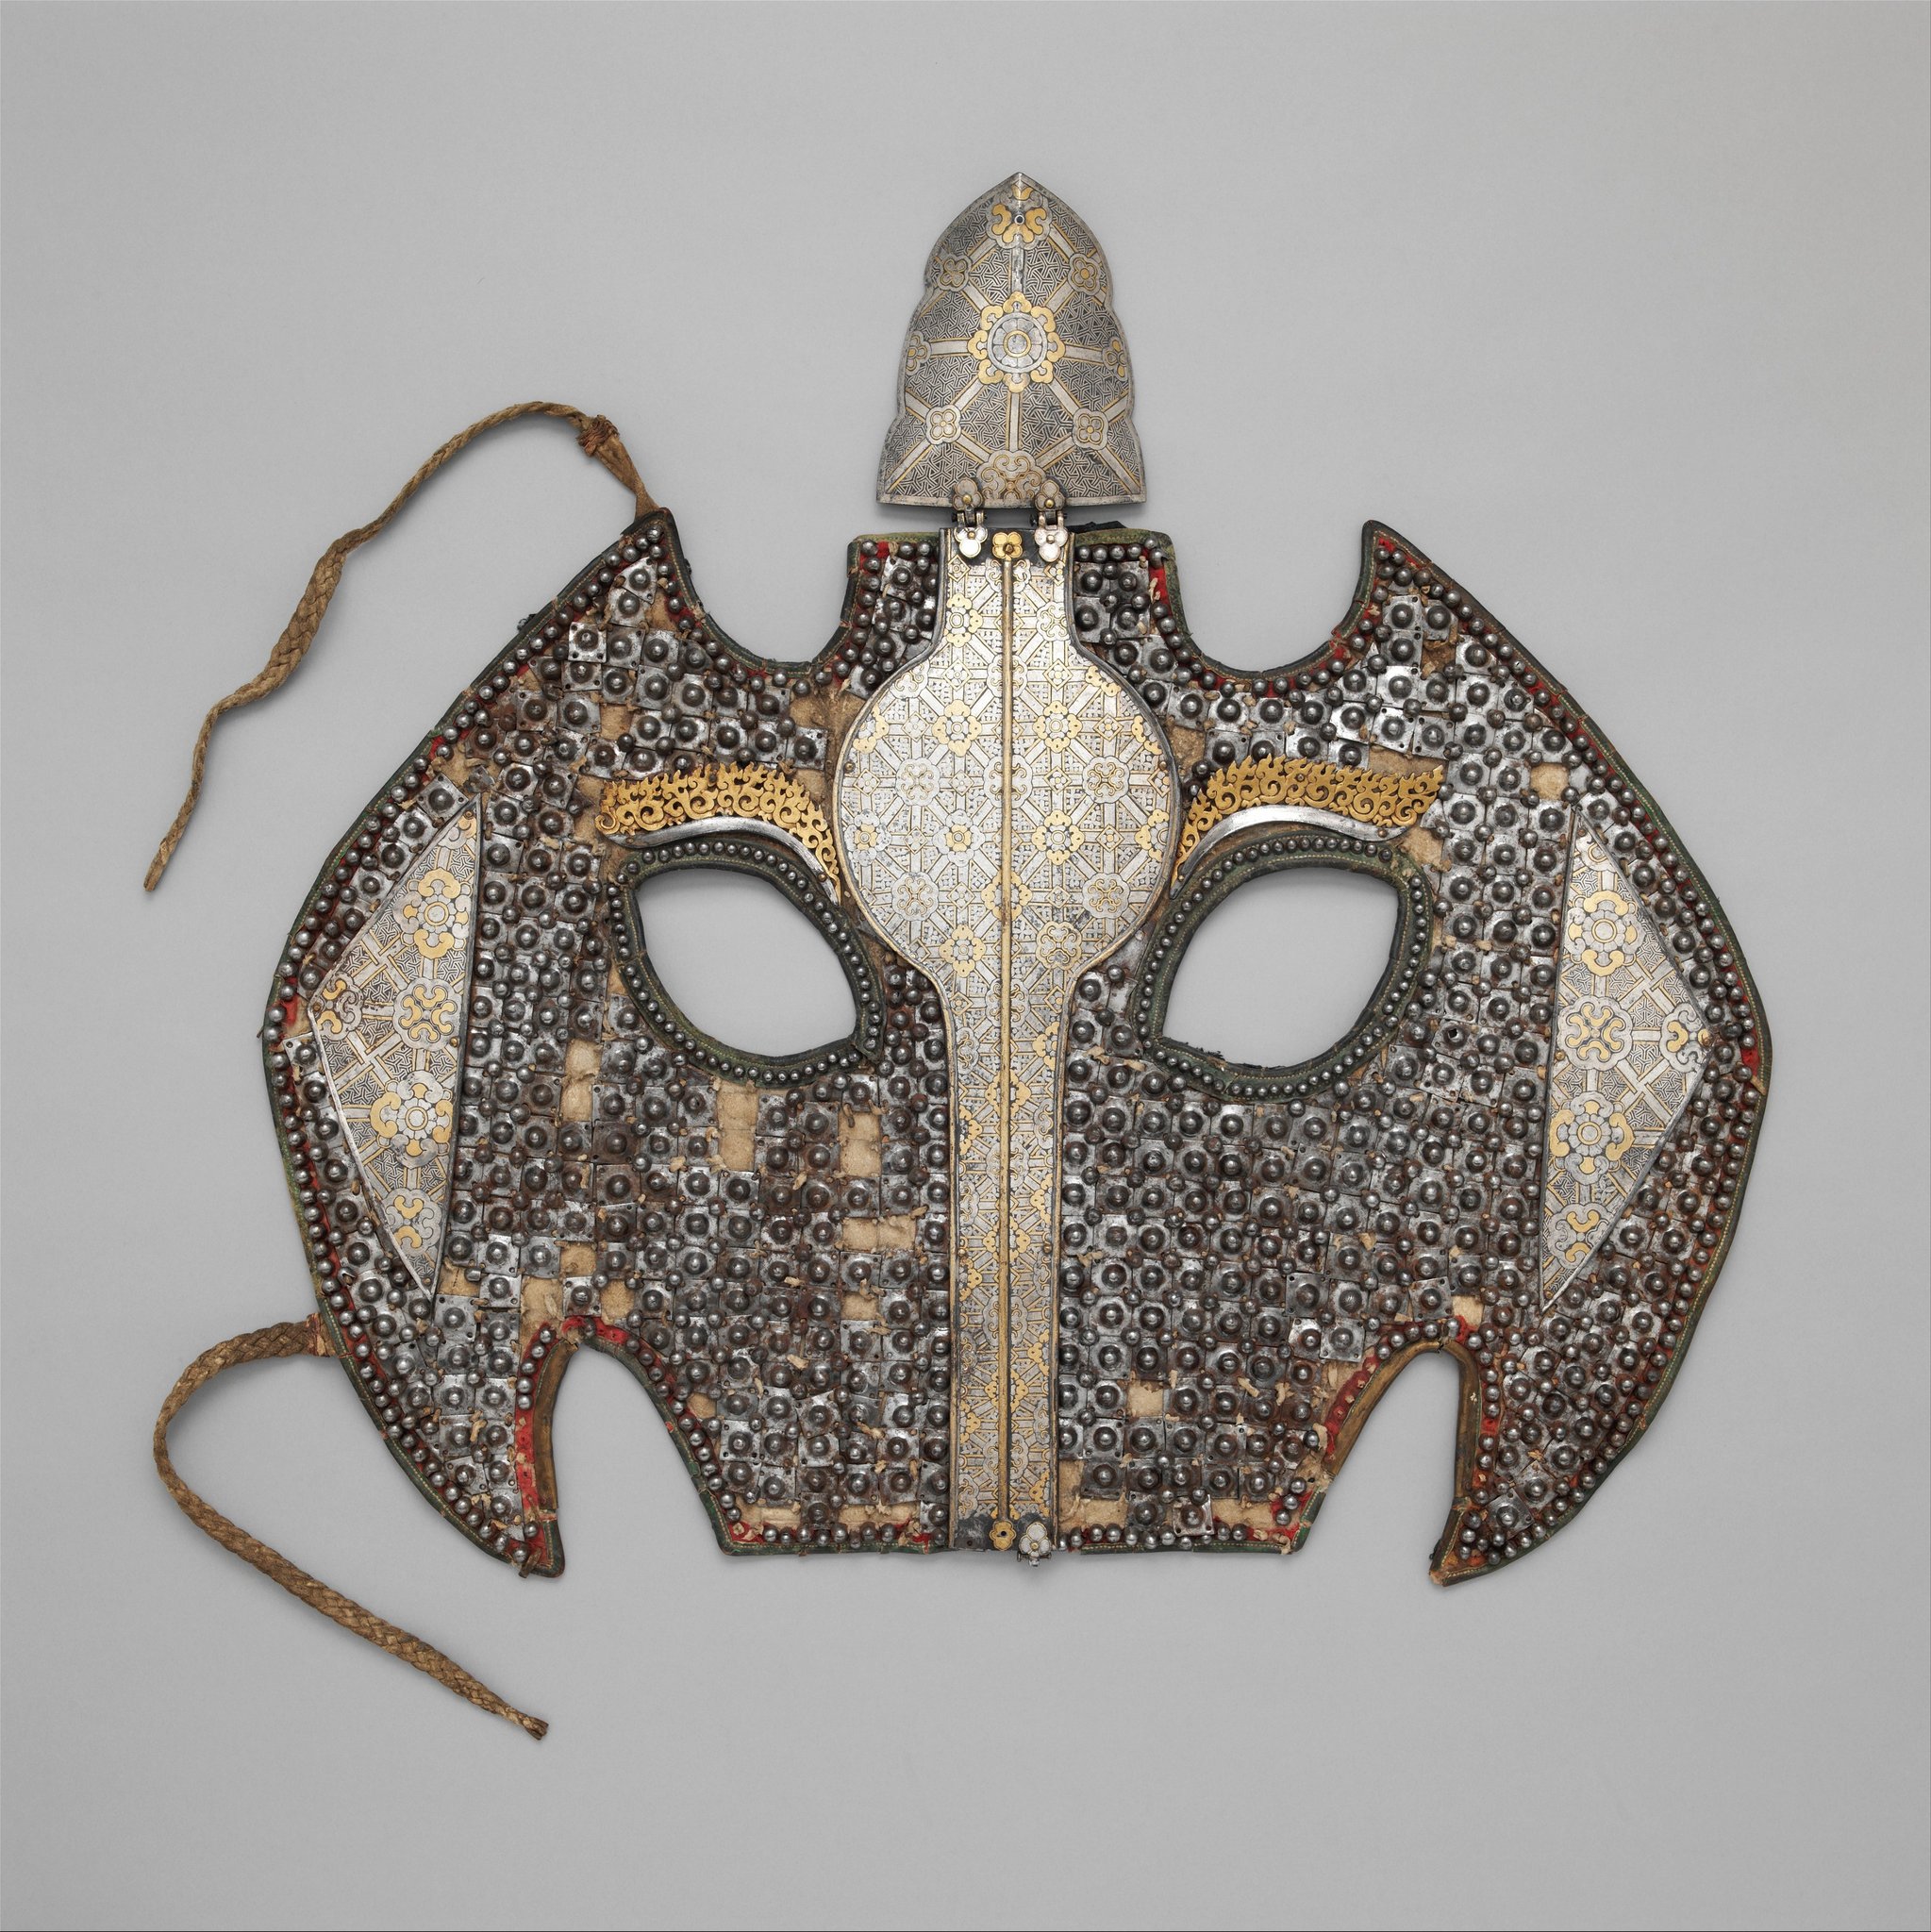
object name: shaffron horse's head defense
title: Shaffron (Horse's Head Defense)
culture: mongolian or tibetan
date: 1467-1633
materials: brass, copper alloy, gold, iron, leather, silver, textile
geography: mongolia